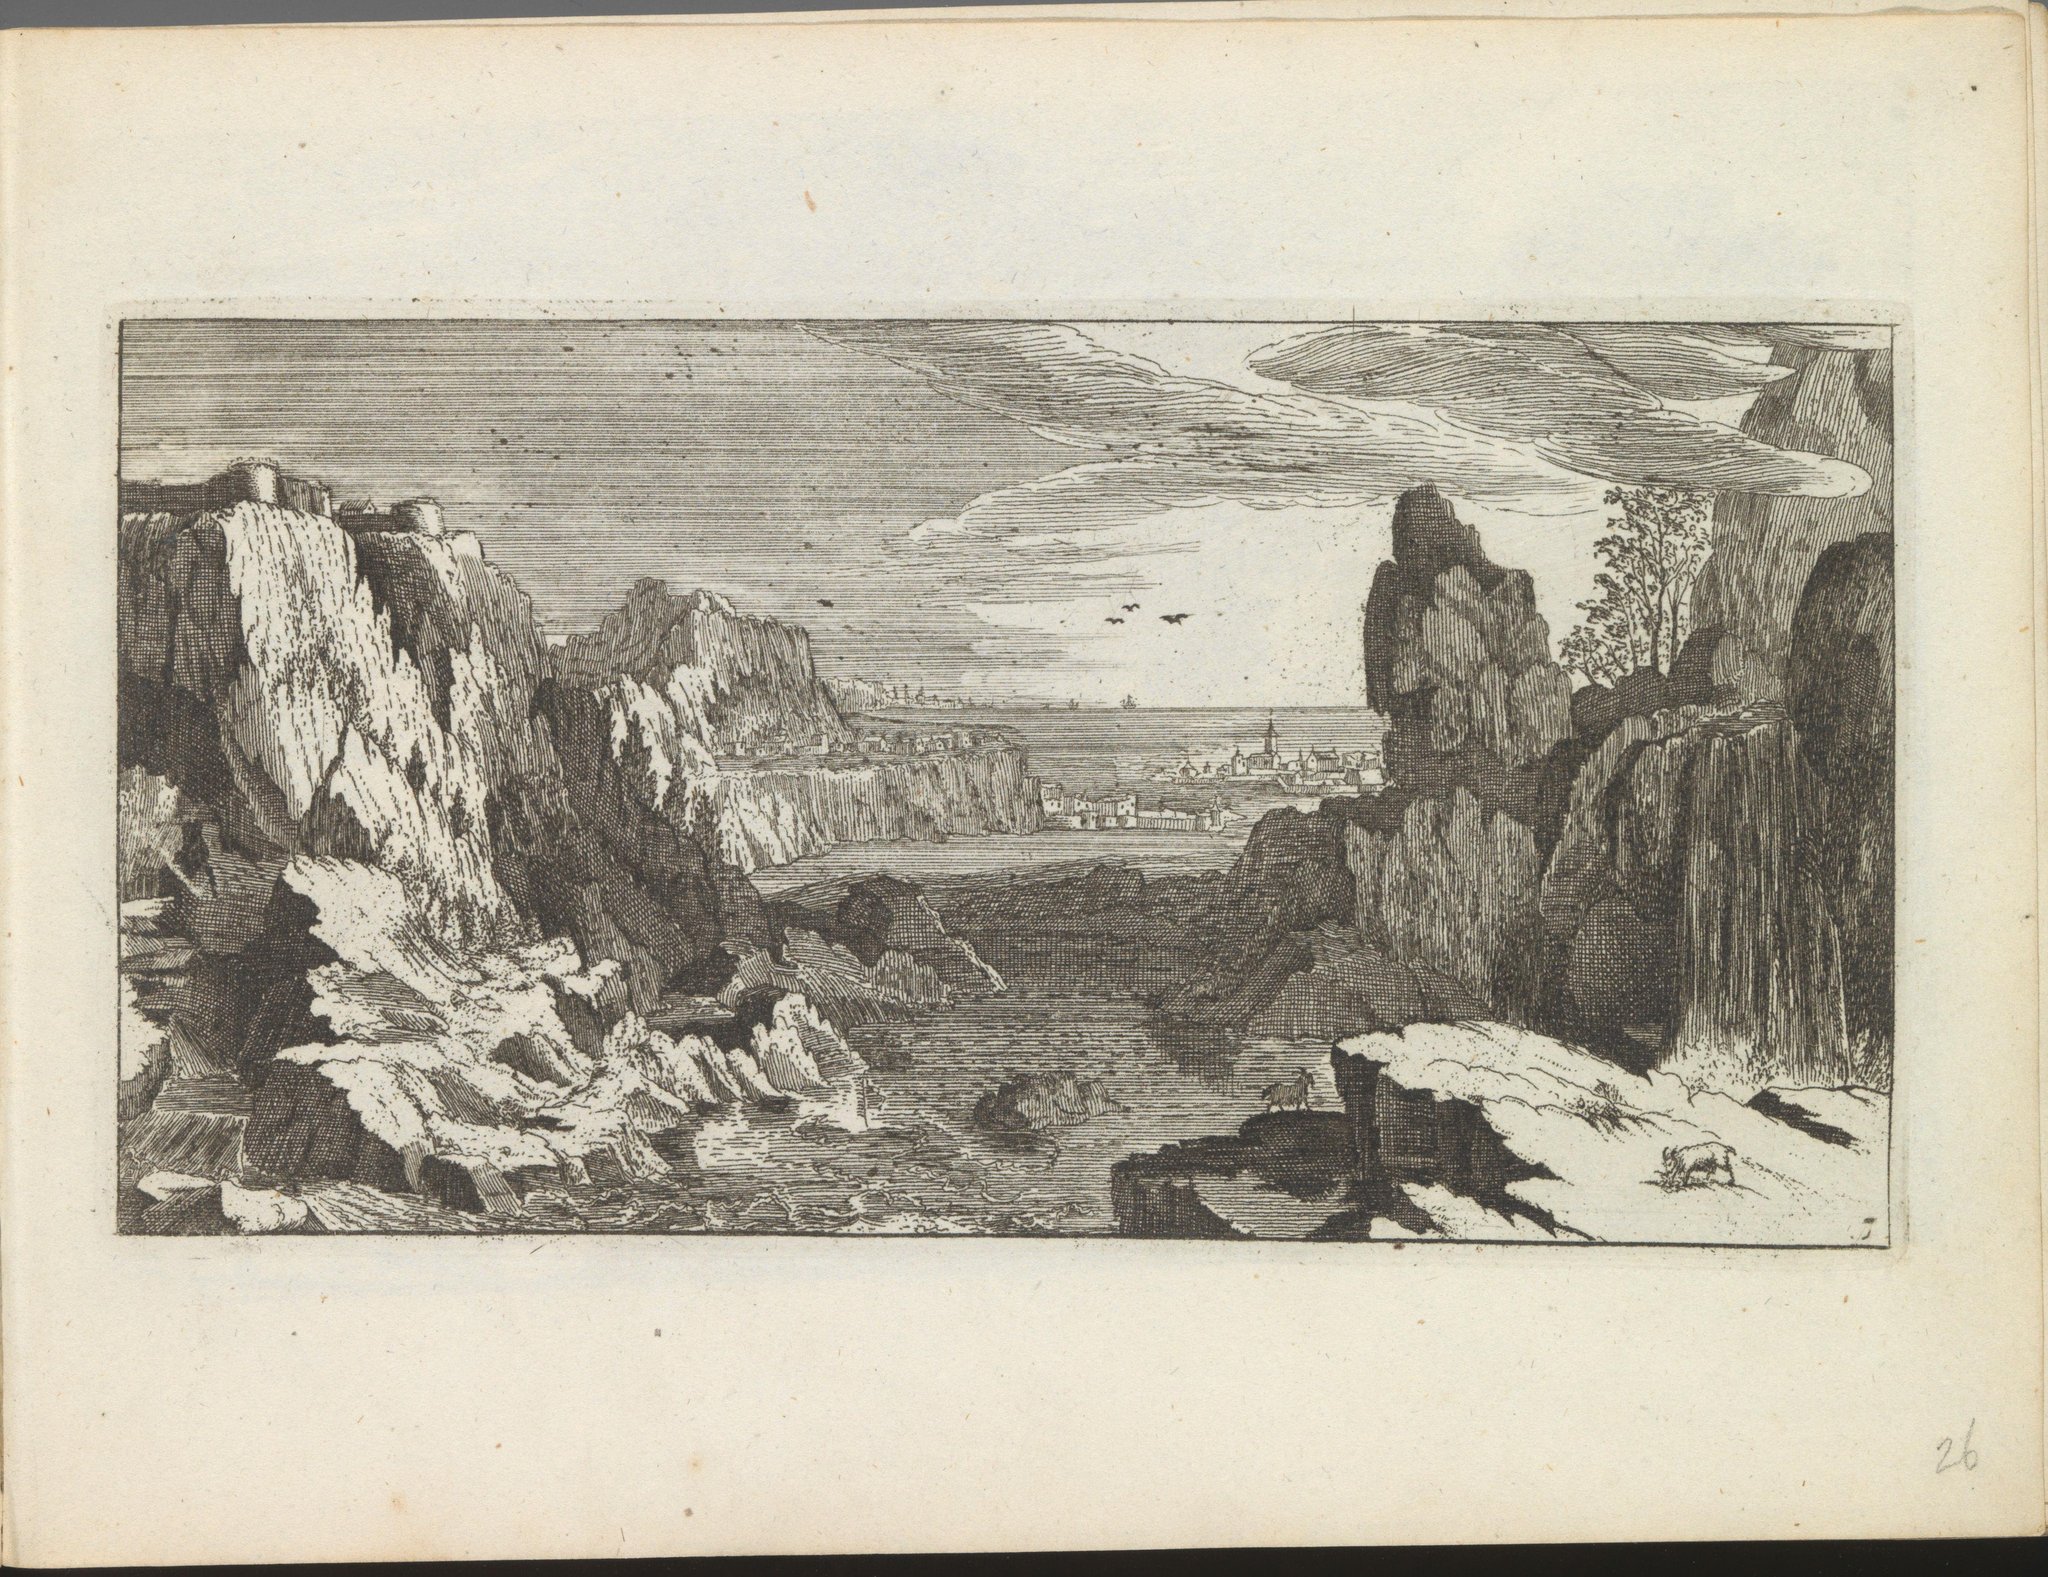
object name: print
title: Spiegel der natuur en school der teekenkunde (...)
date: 1600-1699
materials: paper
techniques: etching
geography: amsterdam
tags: landscapes in the temperate zone, river mouth, estuary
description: Berglandschap met een riviermonding. In de verte een dorpje aan het water. Aan de horizon varen enkele schepen. Rechts op de voorgrond twee geiten. Rechtsonder een onleesbaar serienummer. De prent maakt deel uit van een album.